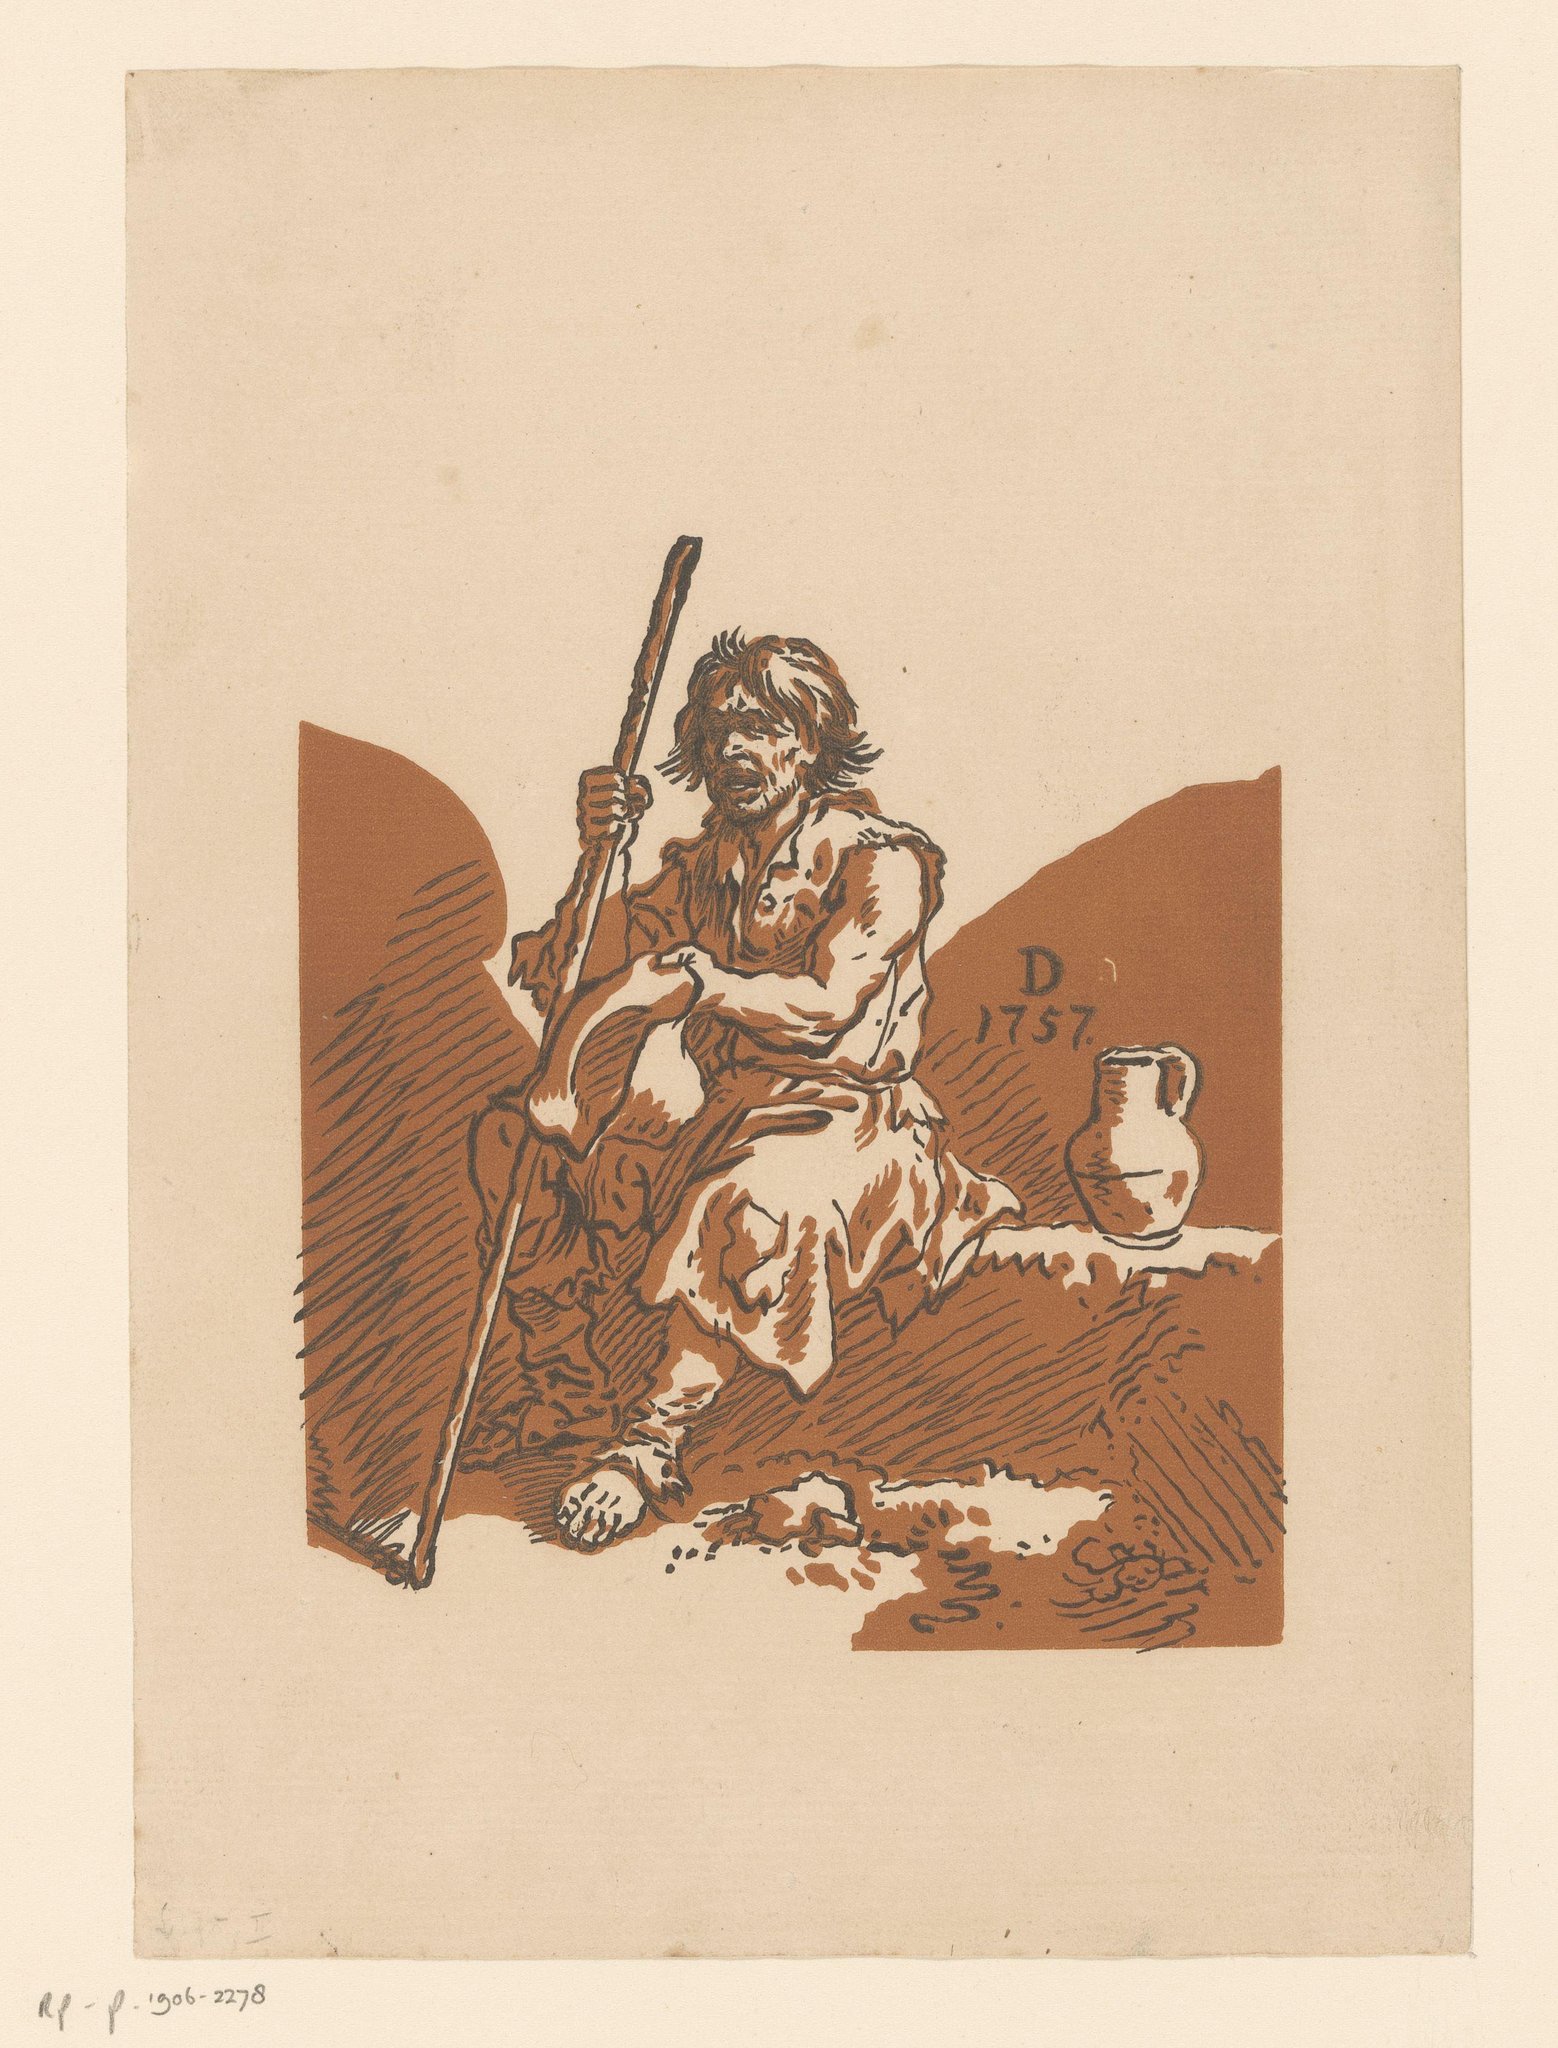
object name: print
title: Blinde bedelaar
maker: christian wilhelm ernst dietrich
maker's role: artist, painter, print maker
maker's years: 1712-1774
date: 1757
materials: paper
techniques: woodcut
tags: blind, blindness, beggar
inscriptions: collector's mark: Lugt 2228